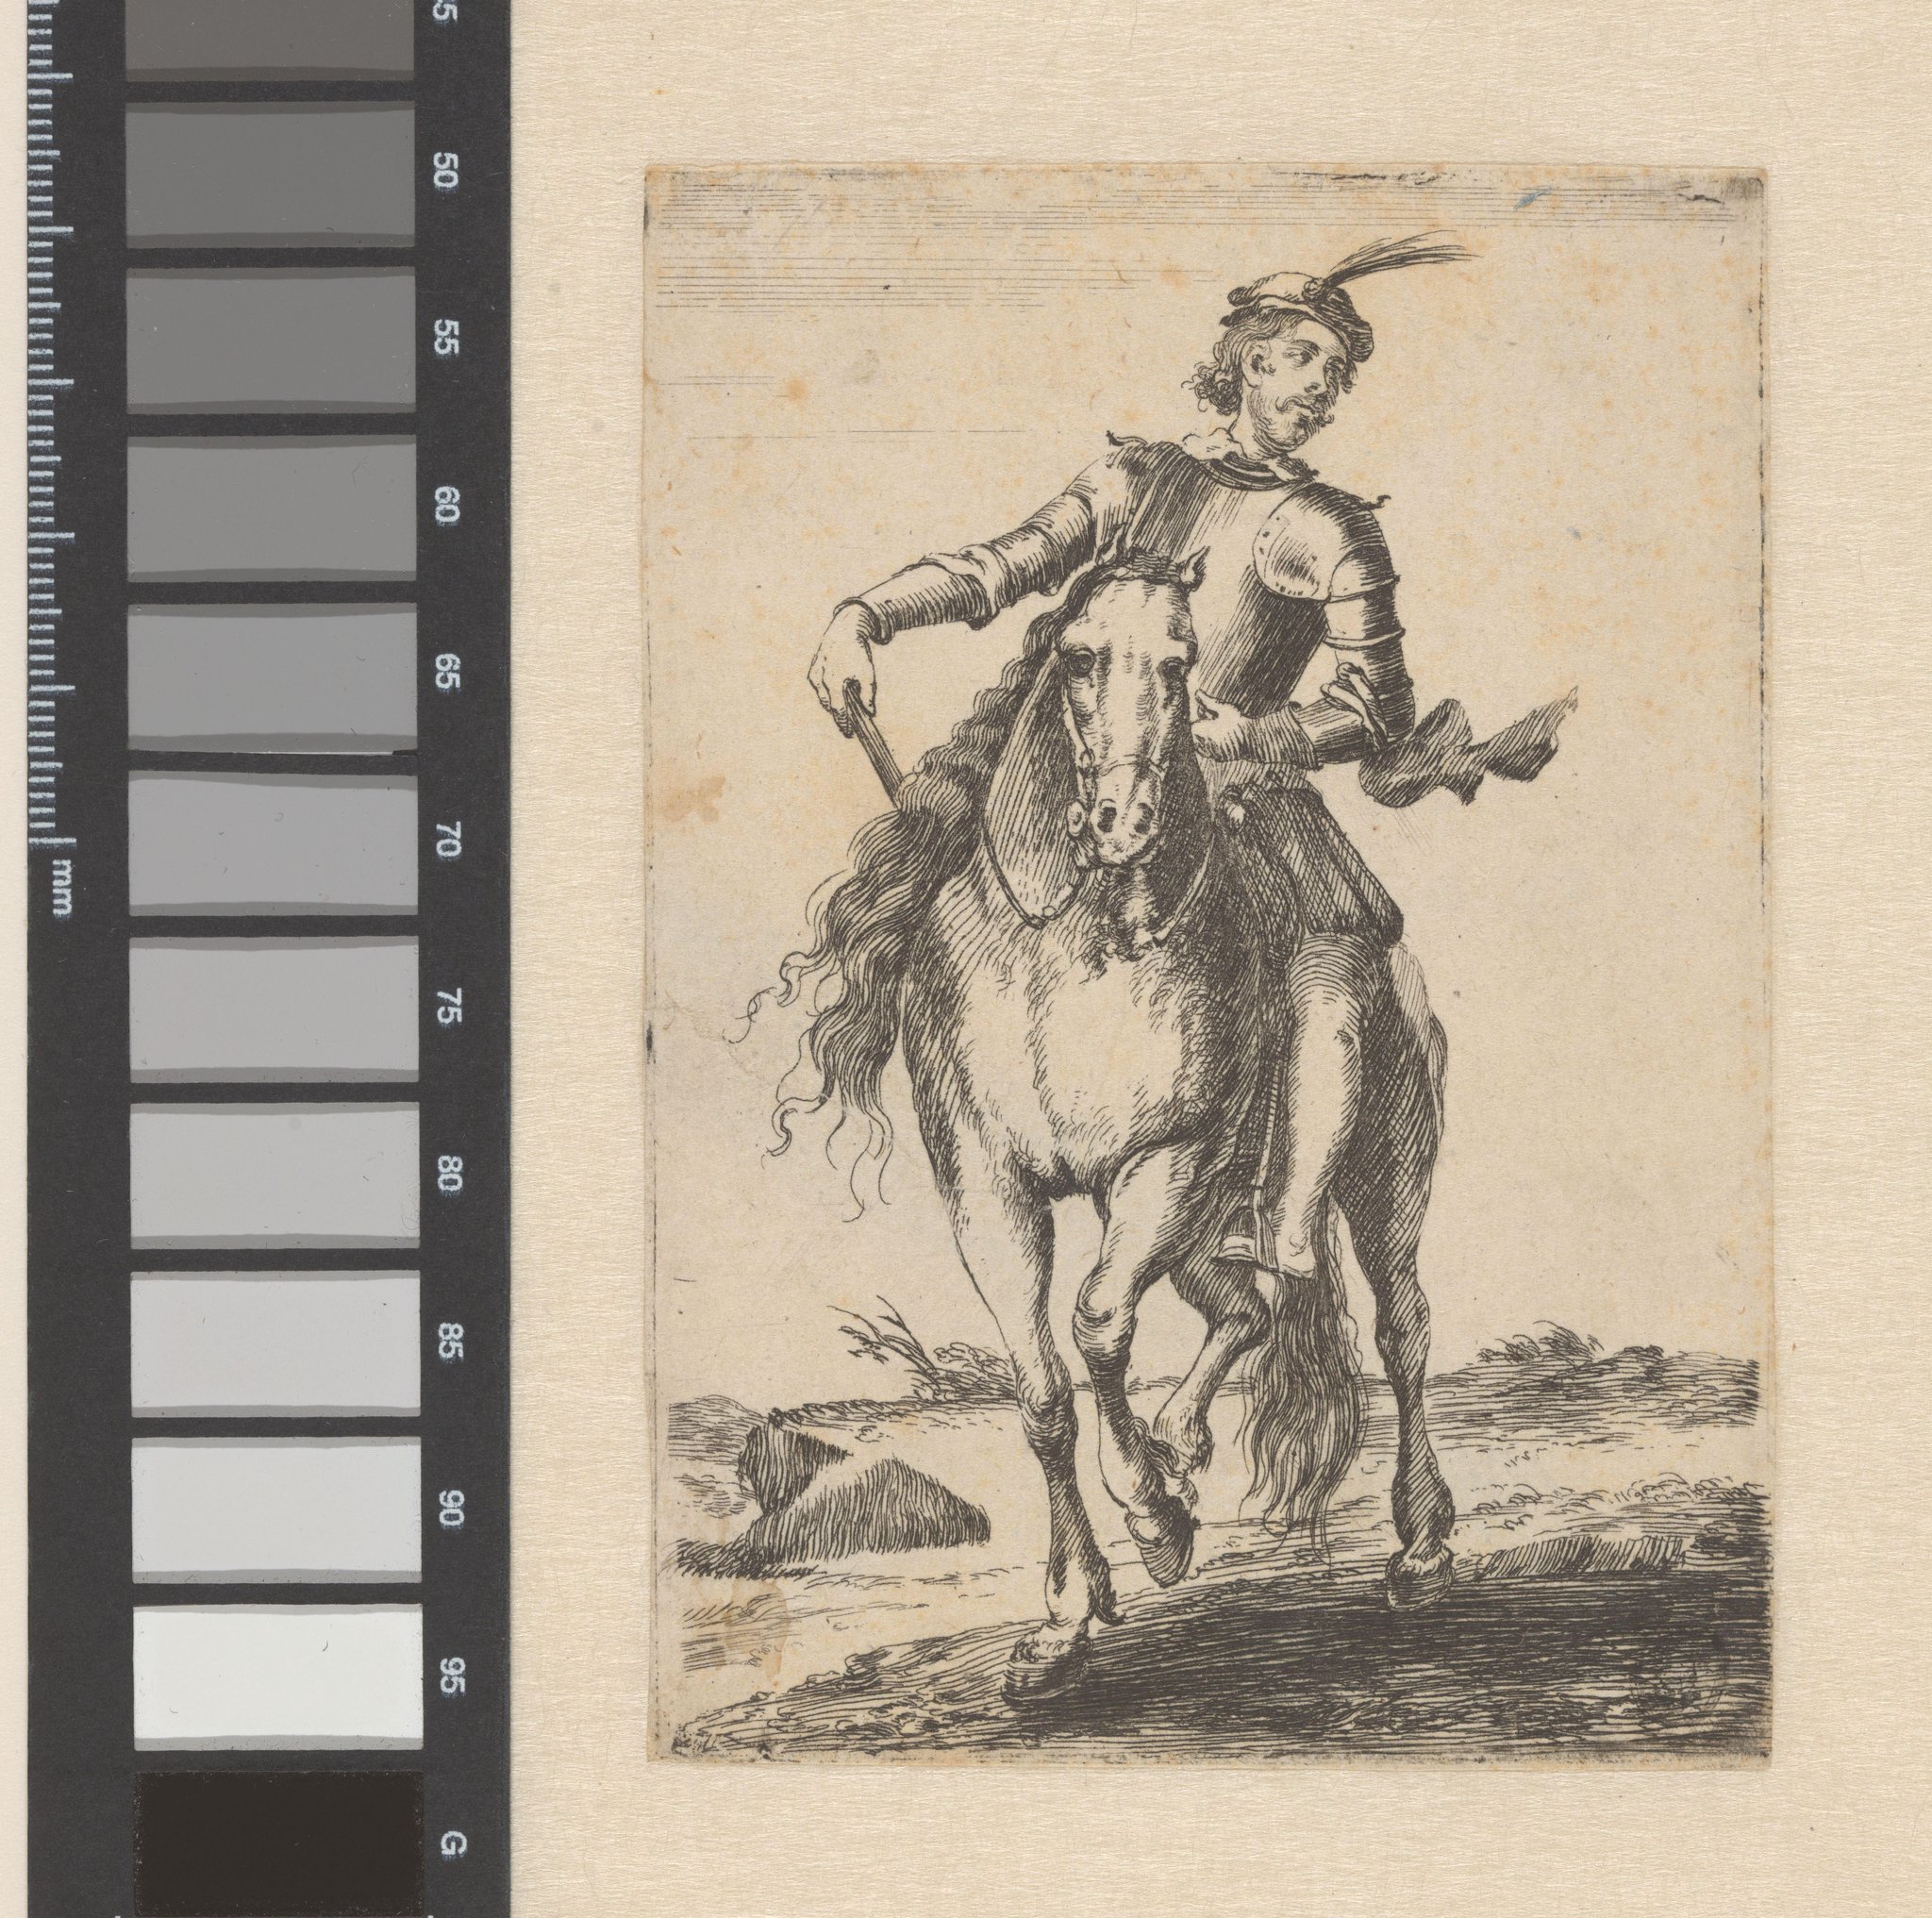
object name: print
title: Oosterling te paard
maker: theodorus van kessel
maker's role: print maker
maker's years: 1620-1660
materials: paper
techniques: etching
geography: low countries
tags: riding a horse, ass, or mule; rider, horseman, asiatic races and peoples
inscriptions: collector's mark: Lugt 2760, collector's mark: Lugt 2228